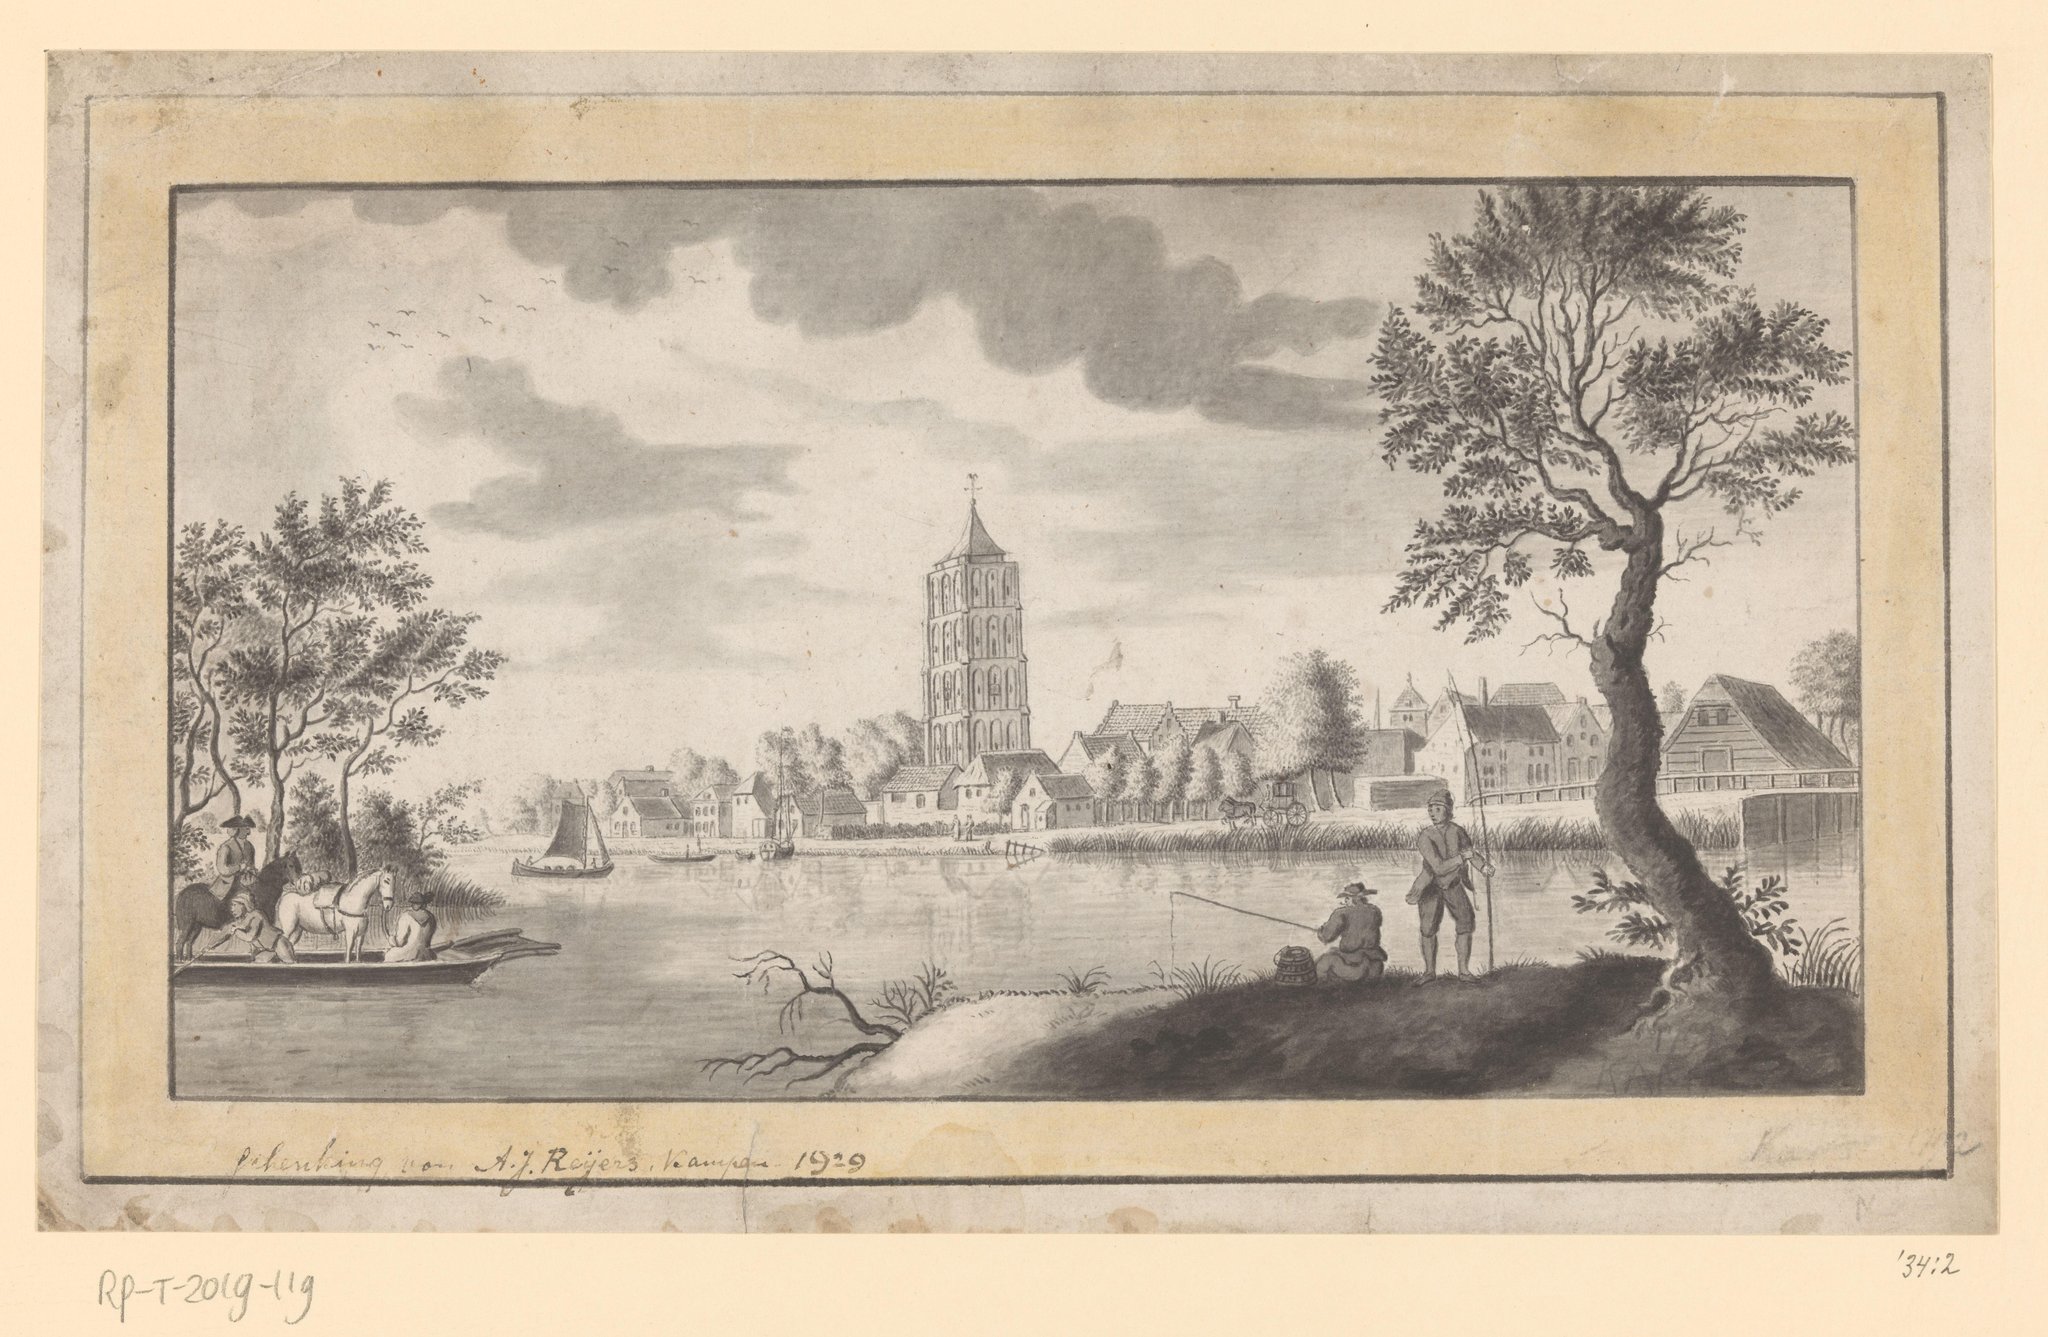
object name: drawing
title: Gezicht op Heukelum vanaf de Linge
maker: arend jan reijers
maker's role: draughtsman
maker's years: 1867-1943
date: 1929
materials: ink, paper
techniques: brush, pen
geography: kampen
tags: river (+ landscape with figures, staffage), prospect of village, silhouette of village (+ city(-scape) with figures, staffage)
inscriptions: date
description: Tekening naar de prent van Philippus van der Schley, zie RP-P-2019-1241.